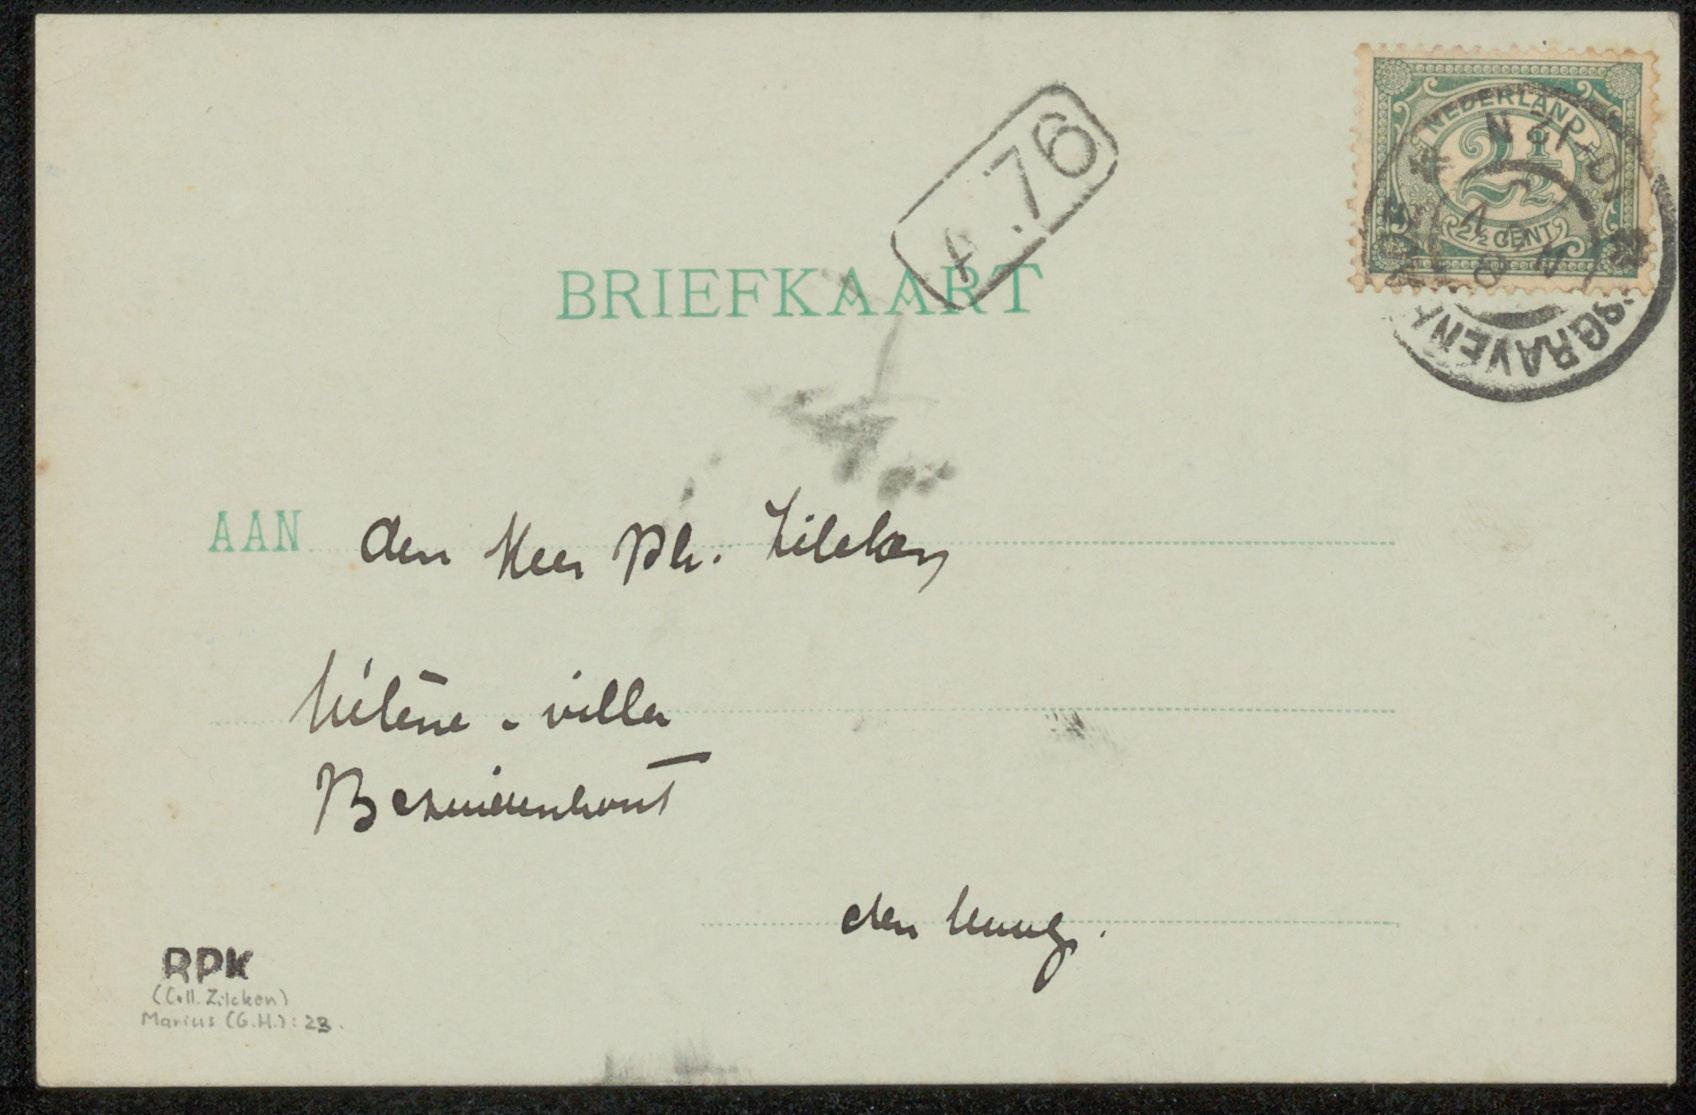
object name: postcard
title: Briefkaart aan Philip Zilcken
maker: grada hermina marius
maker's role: painter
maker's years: 1854-1919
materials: cardboard, ink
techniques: pen, writing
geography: the hague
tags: jozef israëls, dordrecht, amsterdam, print maker, draughtsman, designer, jan veth, lodewijk van deyssel, philip zilcken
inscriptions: collector's mark: ‘RPK’